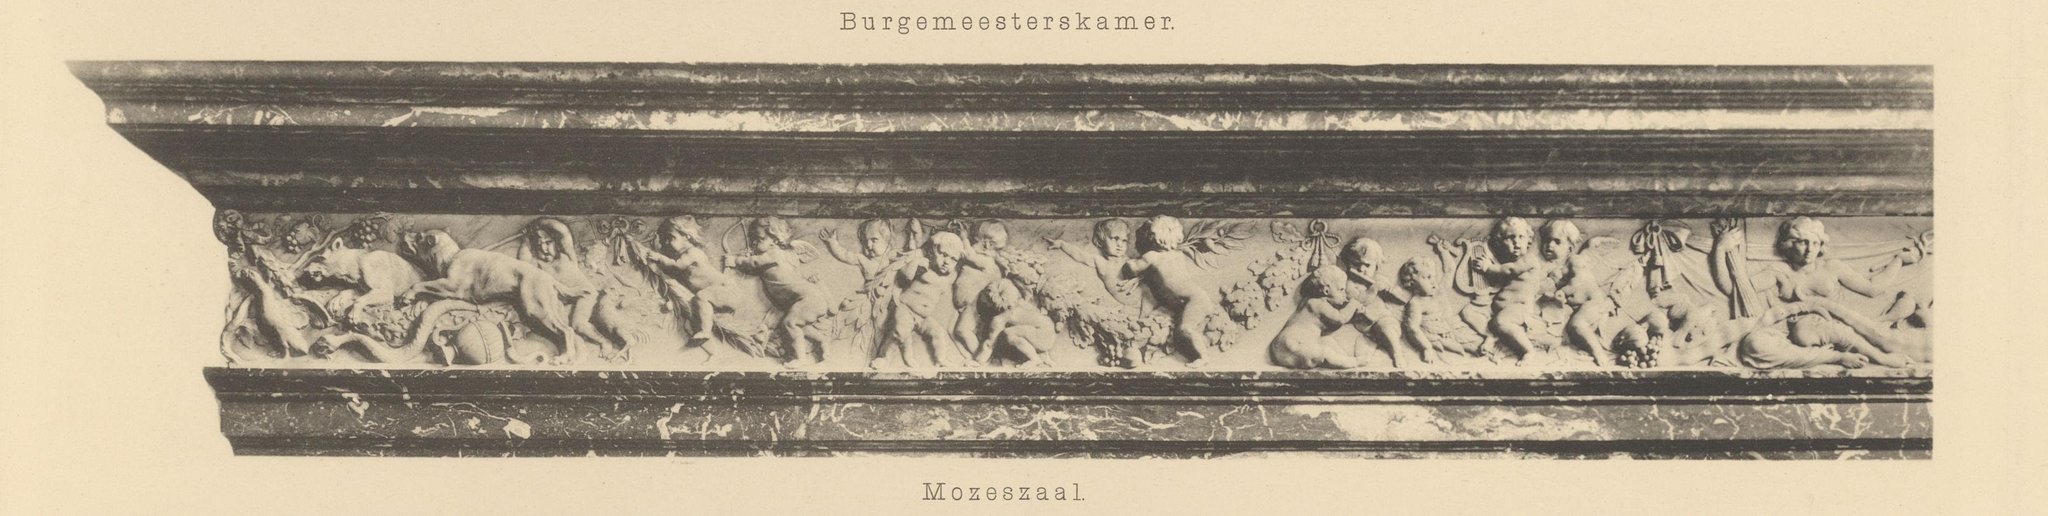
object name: photograph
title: C.T.J. Louis Rieber, Het Koninklijk Paleis te Amsterdam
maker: Anonymous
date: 1899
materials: cardboard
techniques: photograph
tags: open hearth, fire-place, palace, piece of sculpture, reproduction of a piece of sculpture, royal palace of amsterdam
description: Beeldhouwwerken van marmeren schoorsteenmantels. / Mozeszaal.